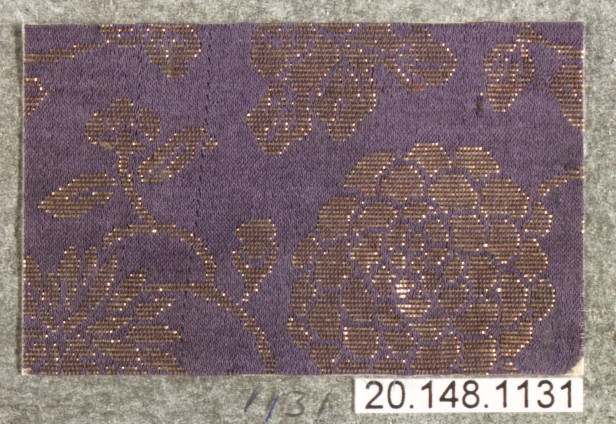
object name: piece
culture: japanese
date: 1801-1900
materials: silk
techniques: compound weave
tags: flowers,leaves